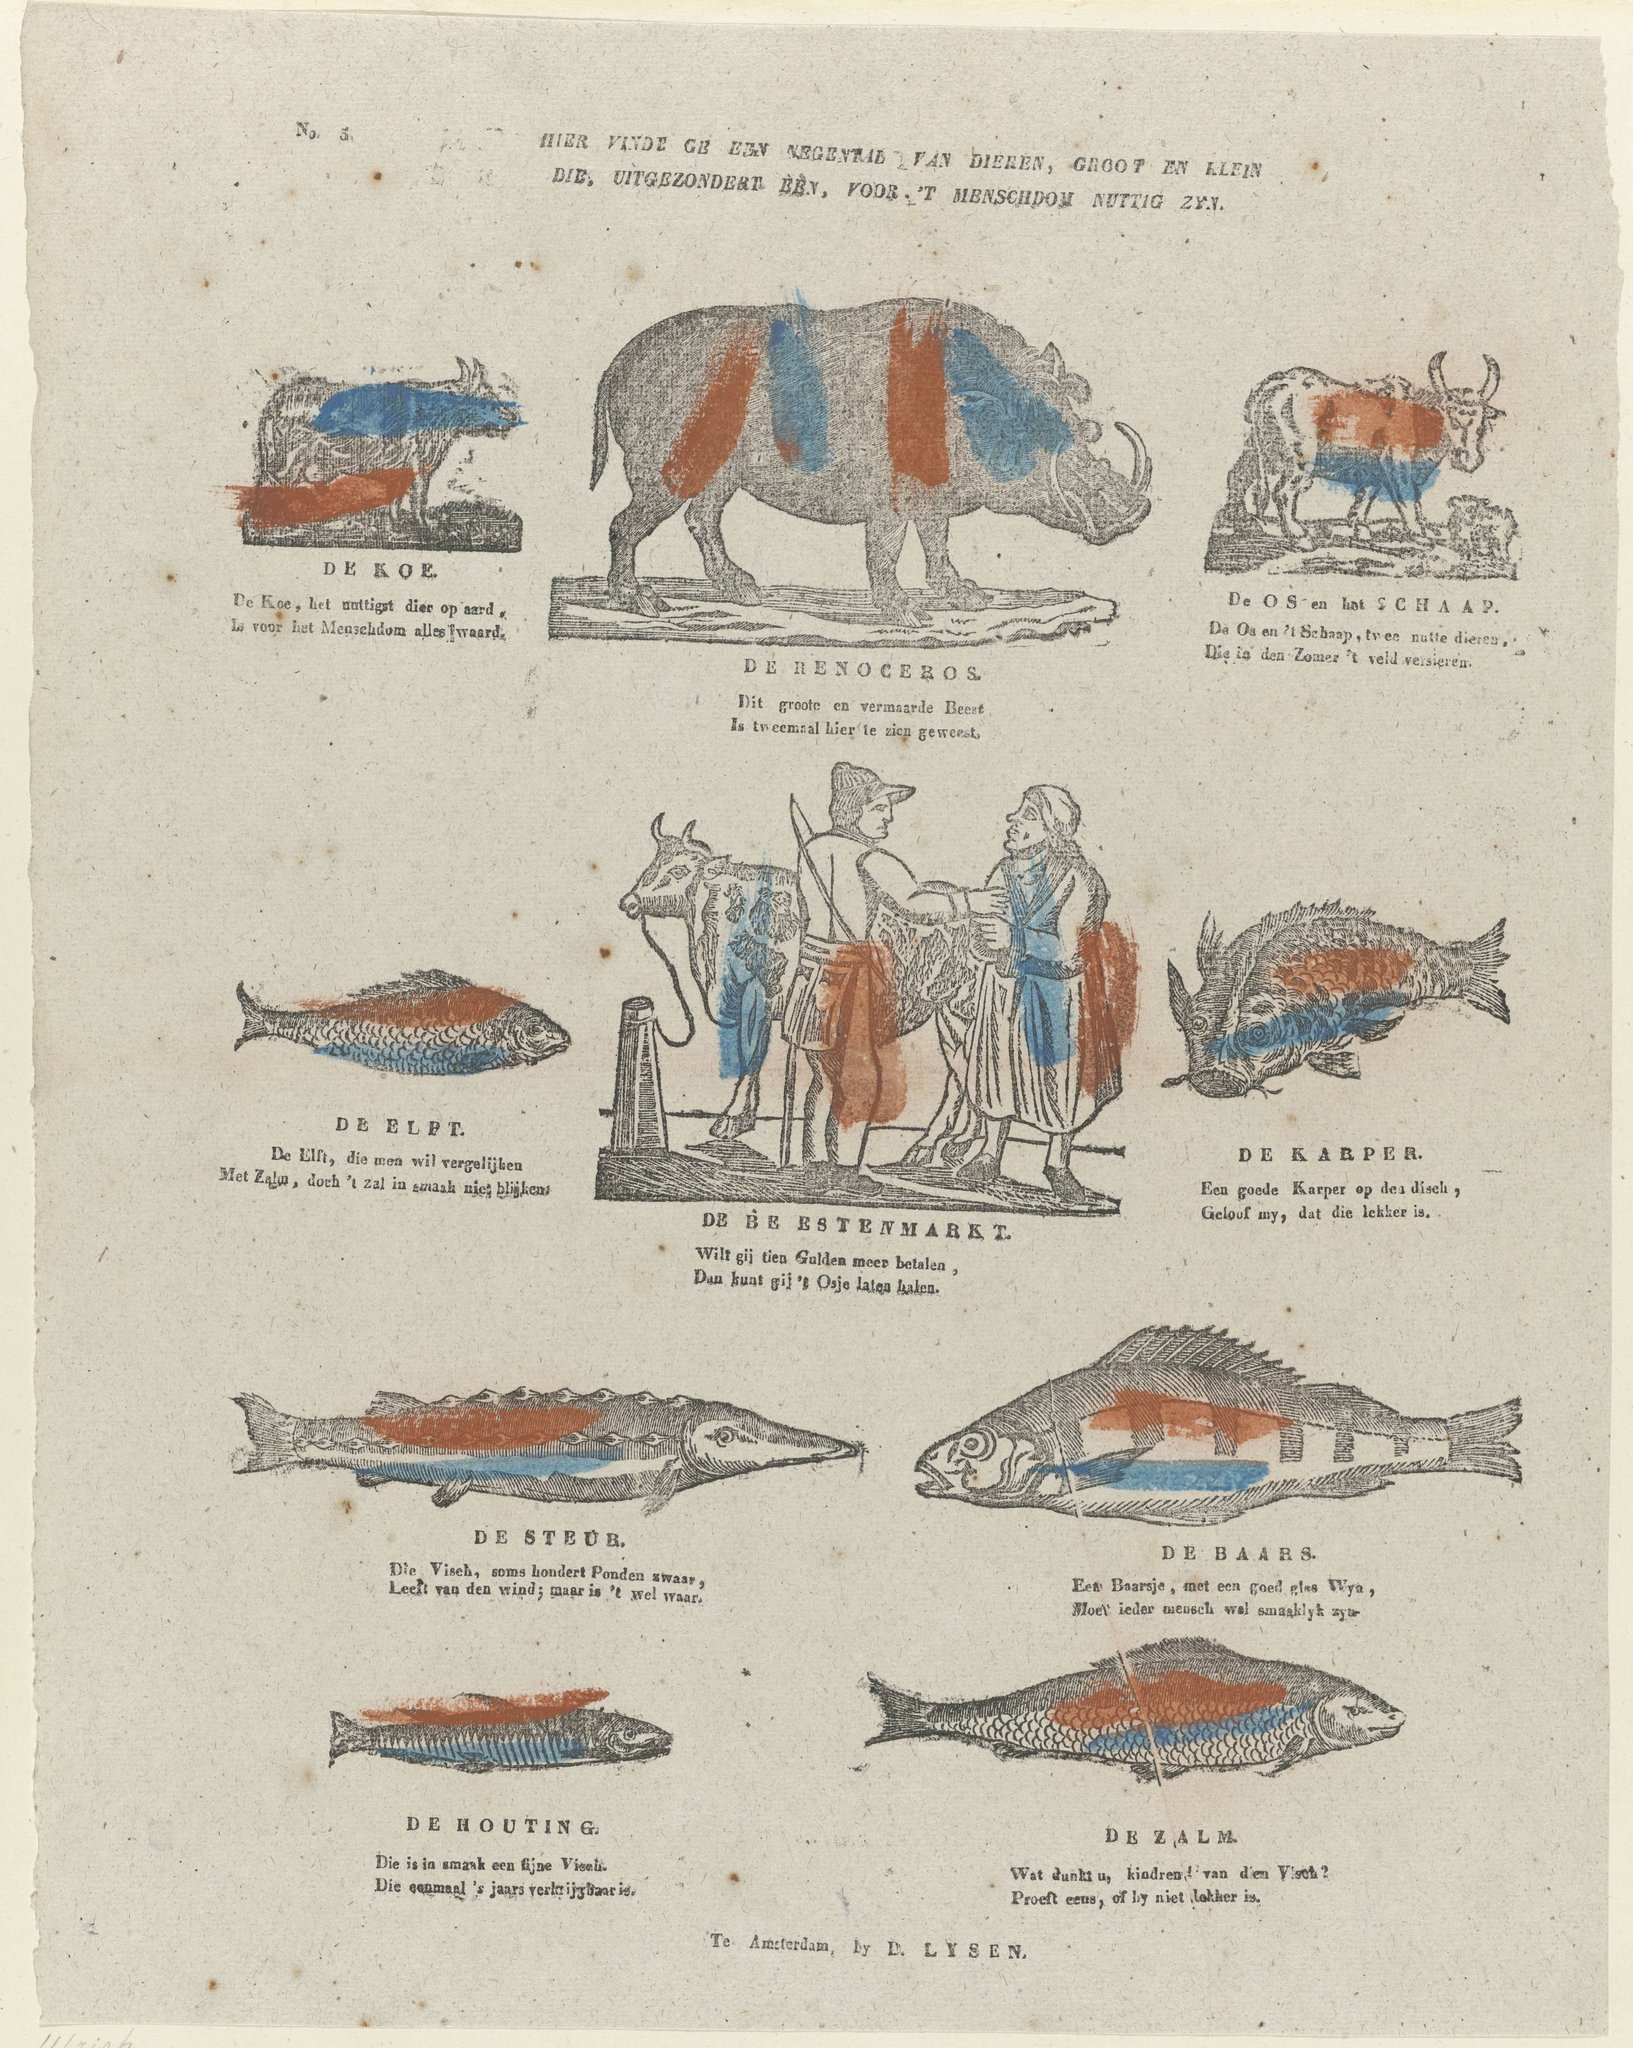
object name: print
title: Hier vinde gij een negental van dieren, groot en klein / die, uitgezondert èèn, voor. 't menschdom nuttig zyn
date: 1836-1849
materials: paper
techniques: colour, letterpress printing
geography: rotterdam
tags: cow, animals, fishes, ox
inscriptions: collector's mark: Lugt 2760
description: Blad met 10 voorstellingen van dieren, waaronder een koe en vissen, en een handelaar en koper op de beestenmarkt. Onder elke afbeelding een titel en een tweeregelig vers. Genummerd linksboven: No. 5.